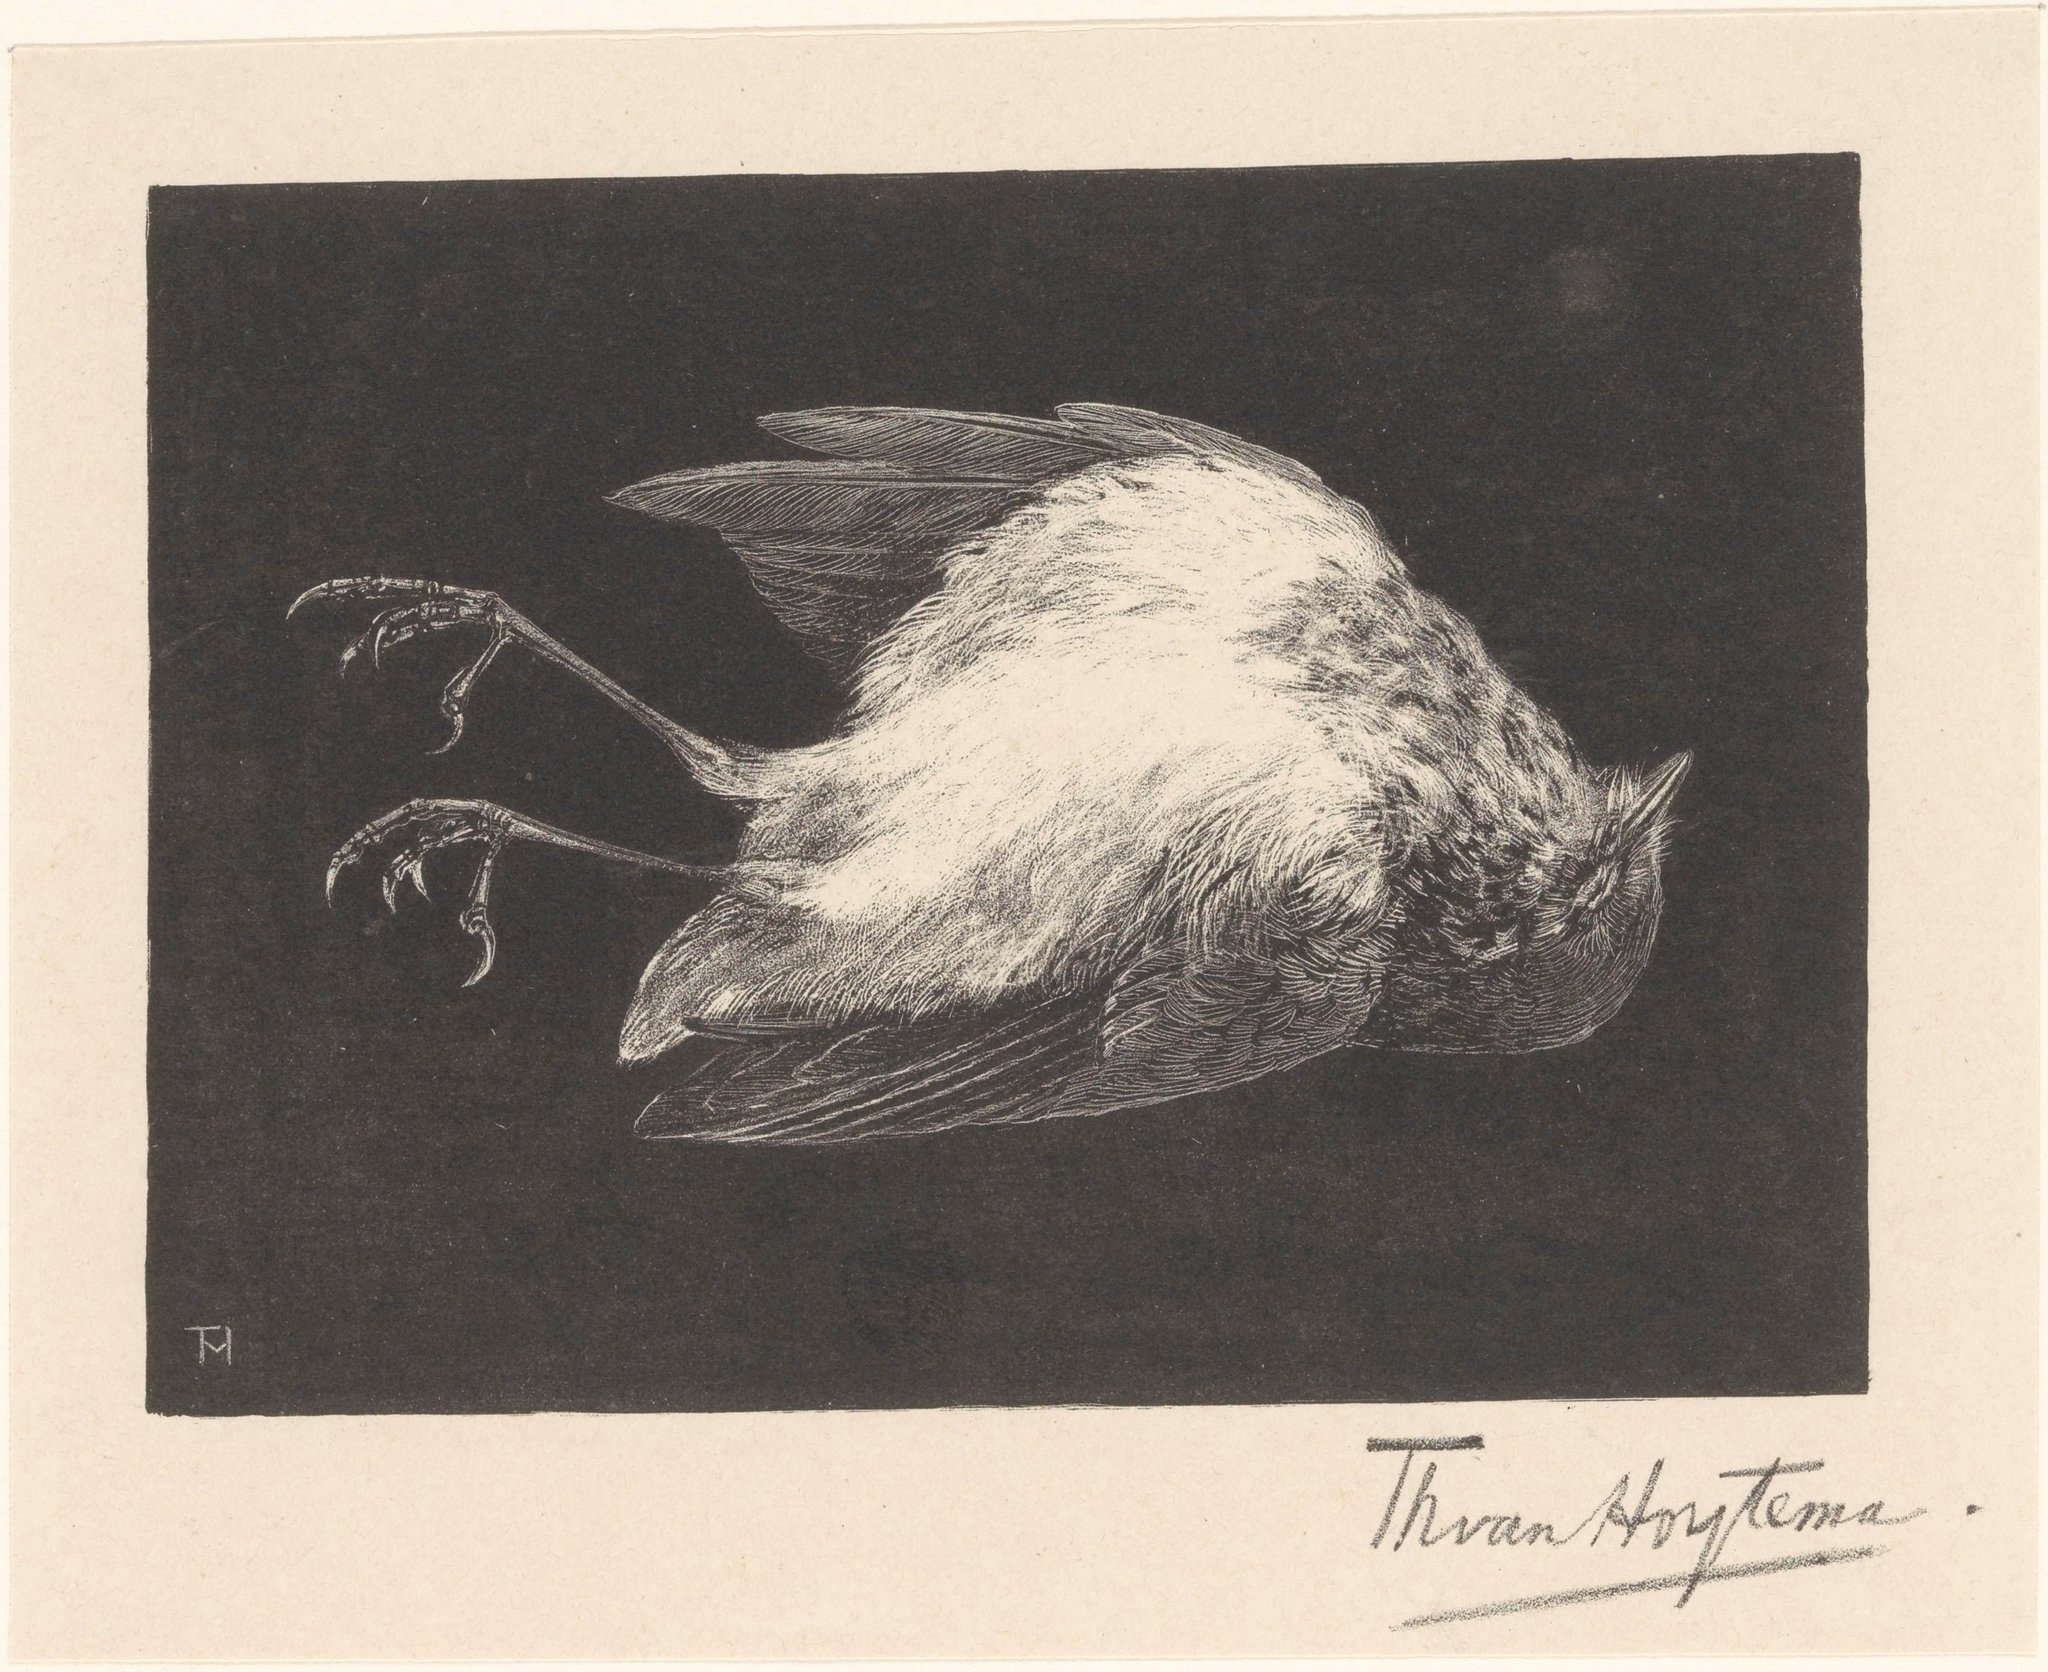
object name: print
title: Dood roodborstje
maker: theo van hoytema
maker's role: draughtsman, painter, print maker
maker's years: 1863-1917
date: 1895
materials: paper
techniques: lithograph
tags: song-birds: robin, birds (+ dying animal; death of animal; dead animal)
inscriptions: collector's mark: Lugt 2233